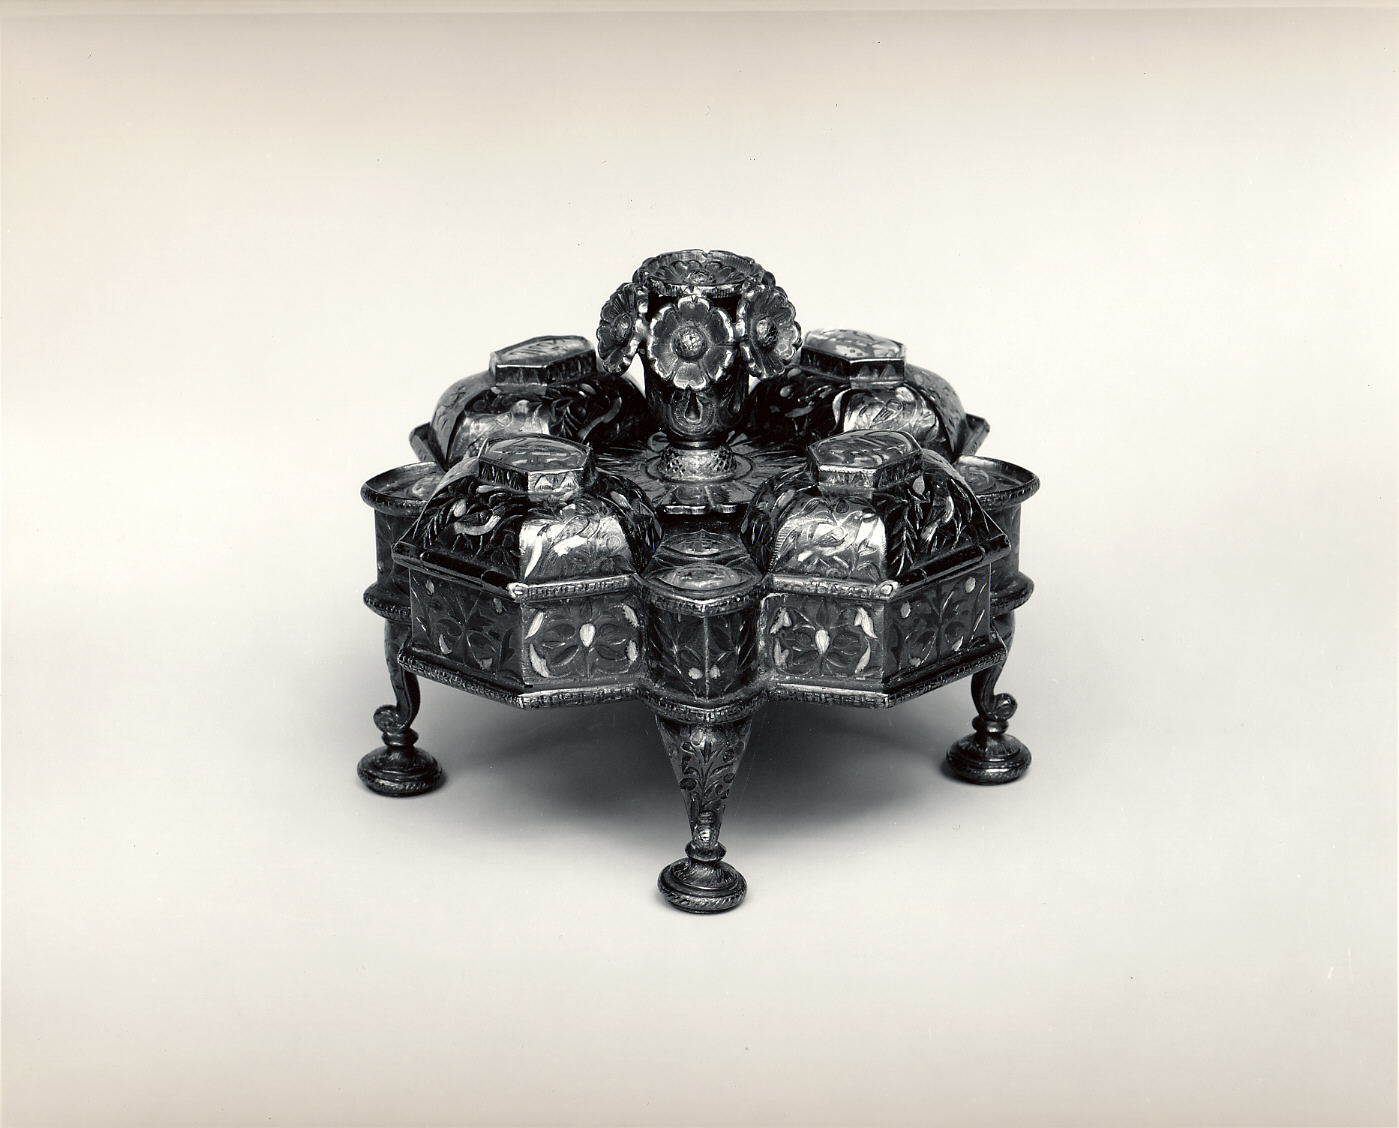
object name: container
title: Perfume Container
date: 1860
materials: enamel, glass, silver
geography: india